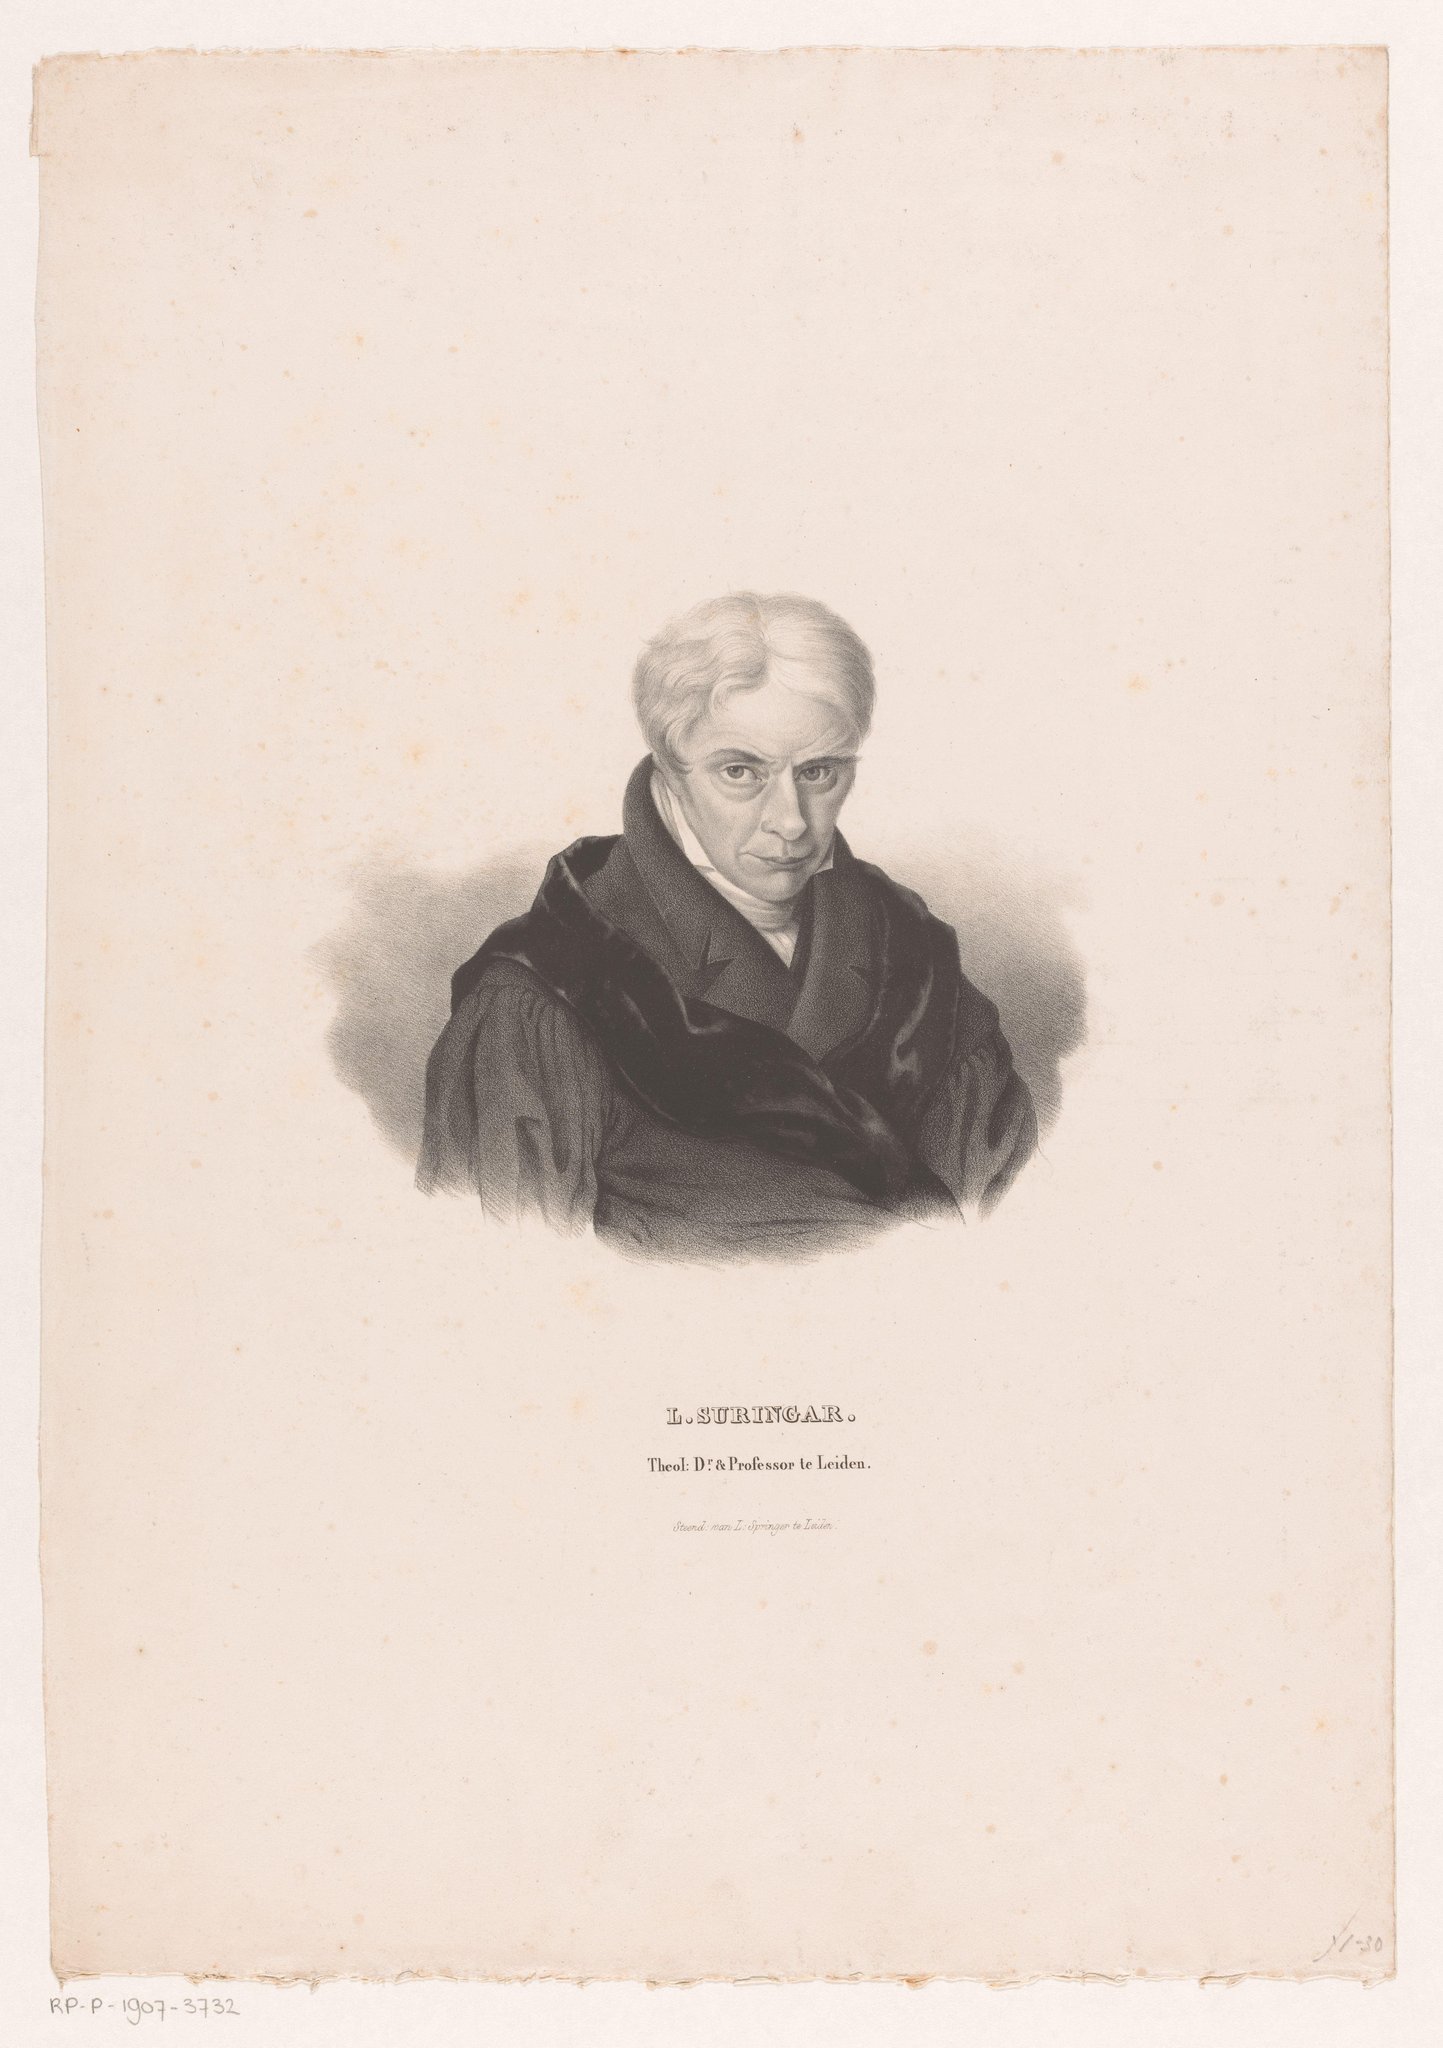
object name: print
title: L. Suringar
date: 1809-1871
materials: paper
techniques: lithograph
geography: leiden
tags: amsterdam, historical persons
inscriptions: collector's mark: Lugt 2228